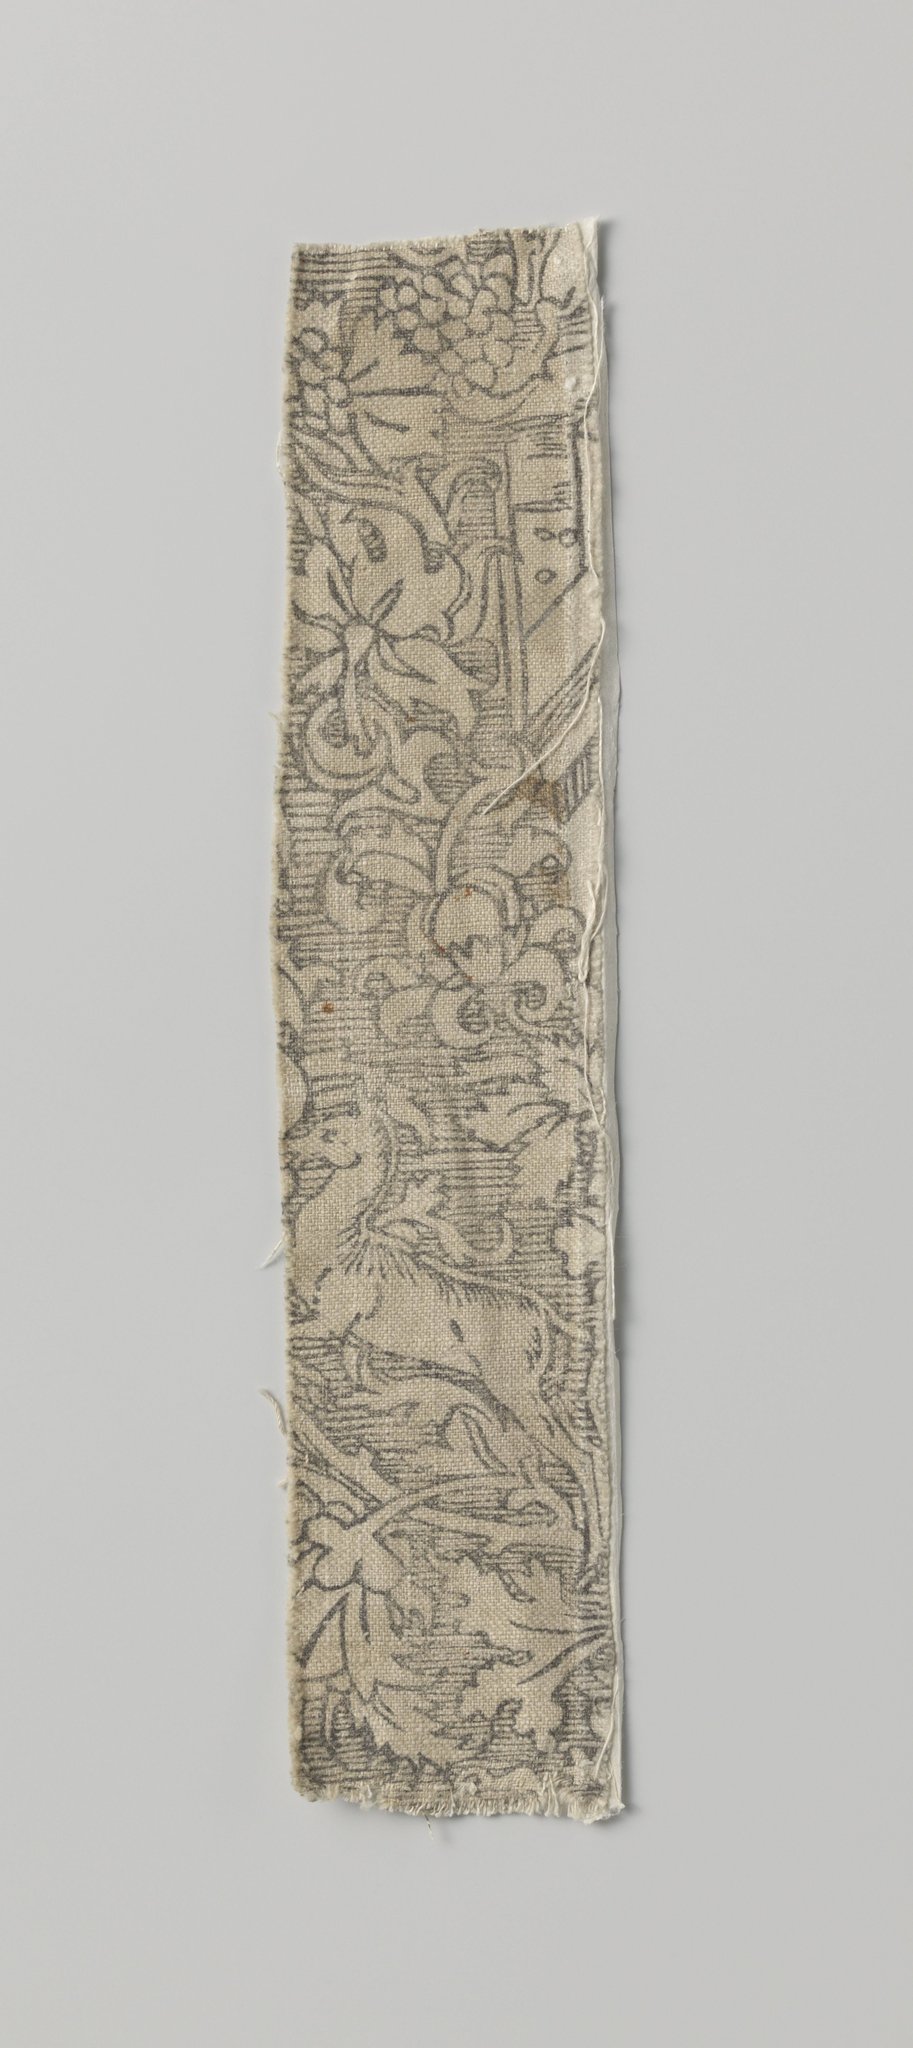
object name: fragment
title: Fragment bedrukt katoen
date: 1850-1899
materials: cotton, linen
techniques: printing, weave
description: Fragment van bedrukt katoen. De opdruk is zwart en heeft een patroon van blad- en bloemranken en een dier (hert ?).